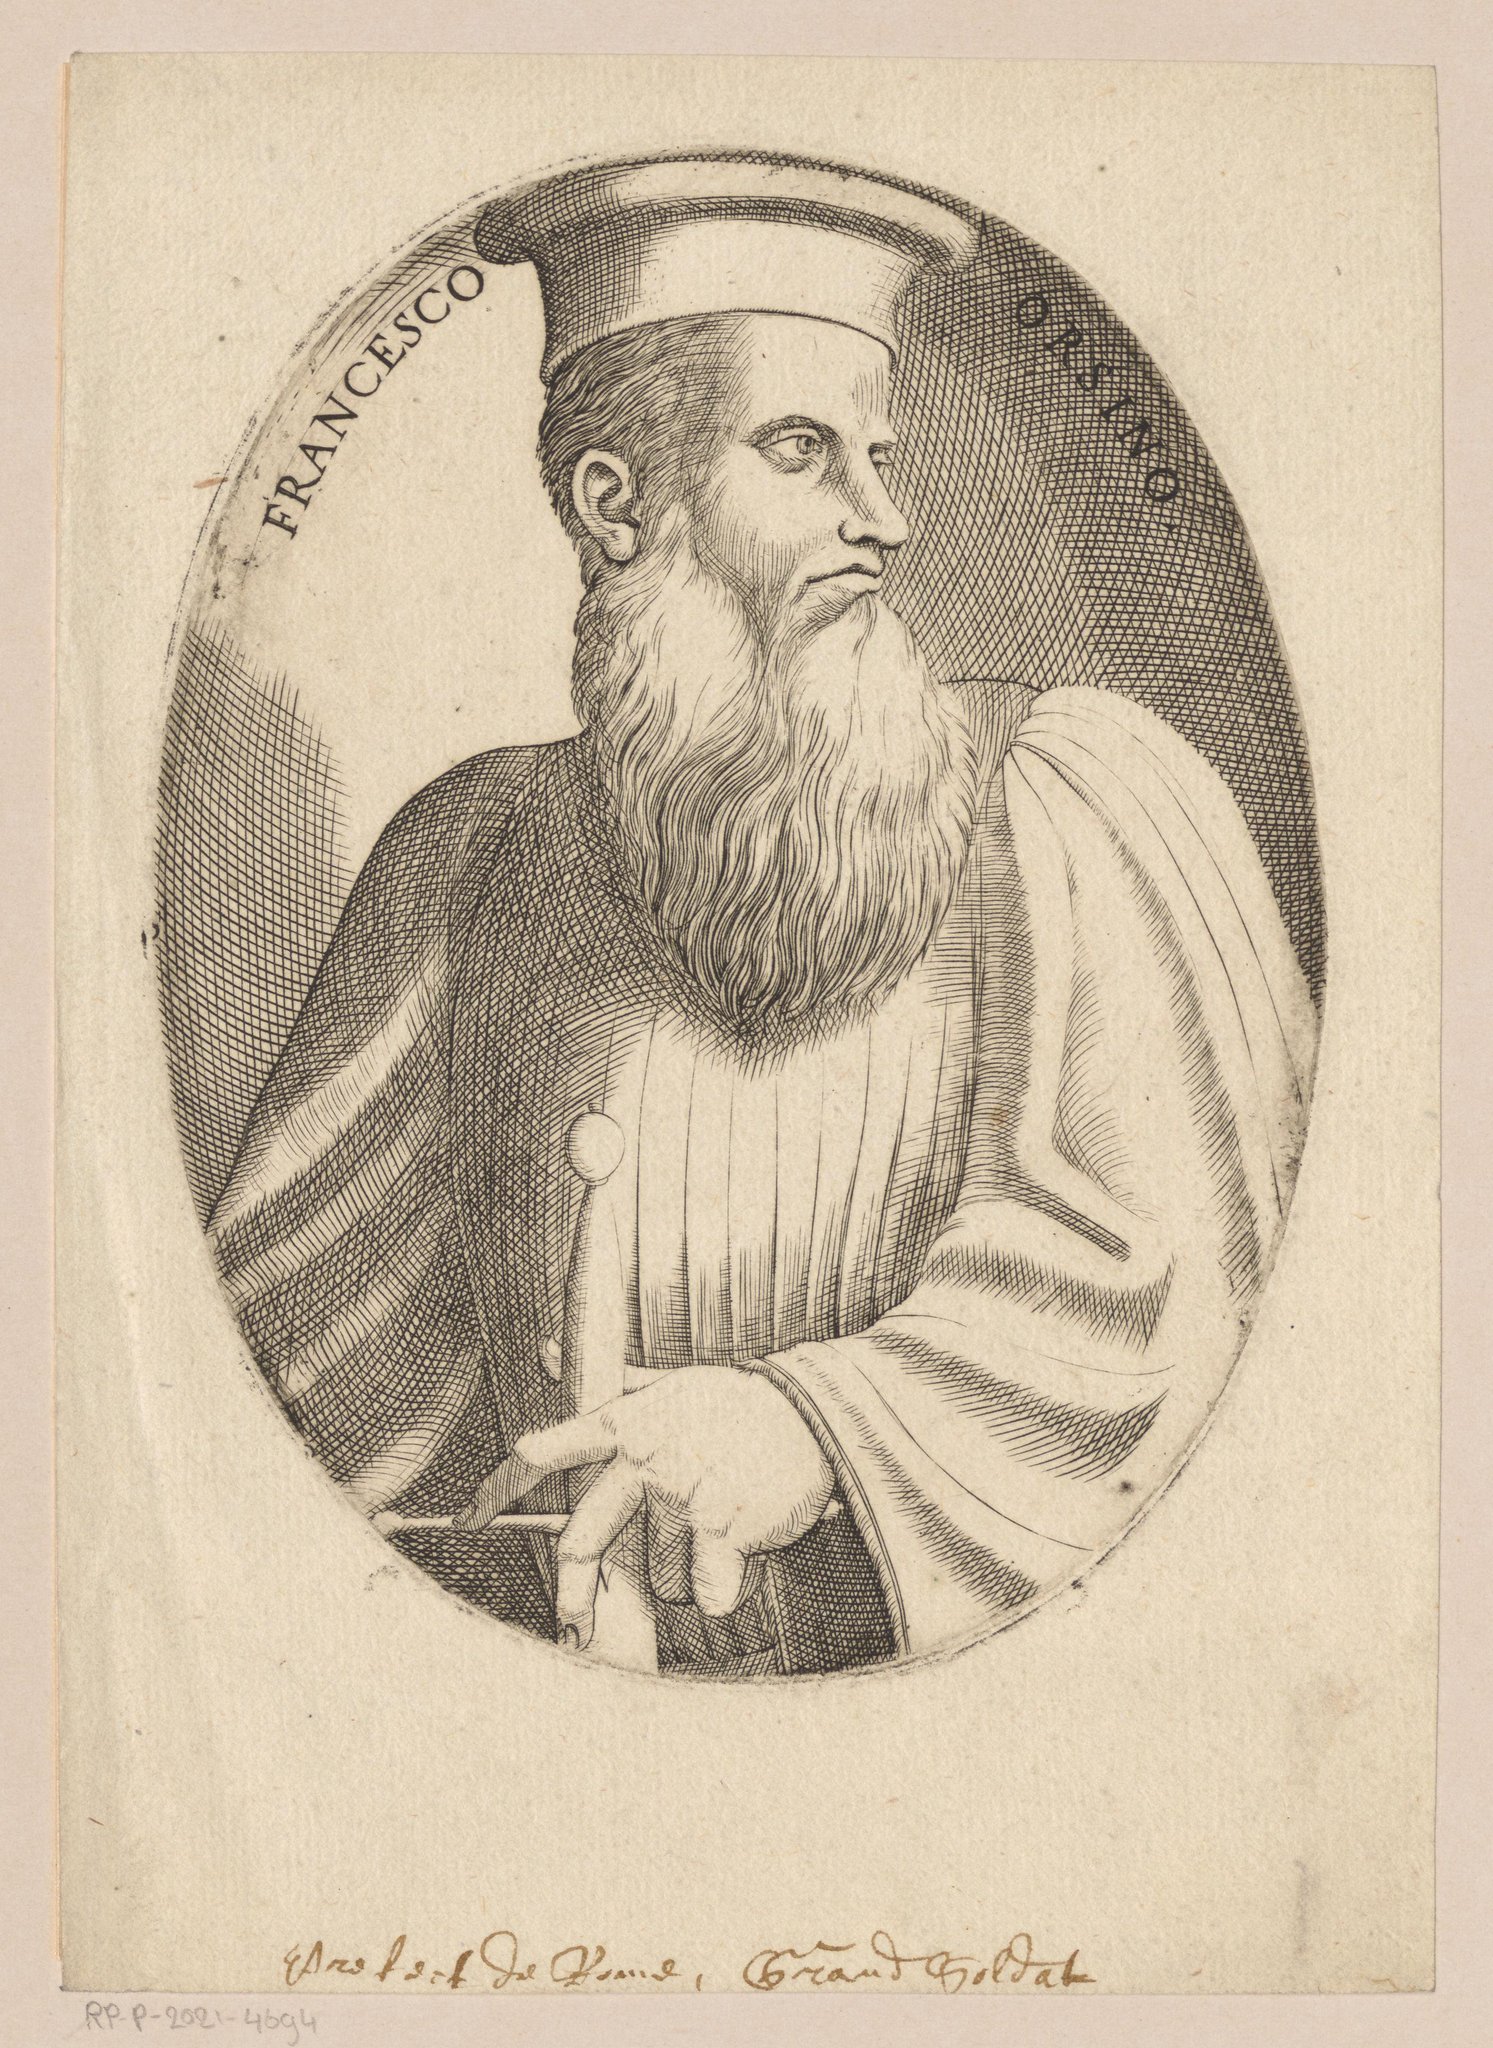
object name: print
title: Portret van Francesco Orsini, hertog van Gravina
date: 1565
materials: paper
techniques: engraving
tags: historical persons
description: Prent met omlijsting gebruikt in: Sansovino, Francesco. L'Historia di Casa Orsina di Francesco Sansovino. Venetië: Filippo en Bernardino Stagnino, 1565.